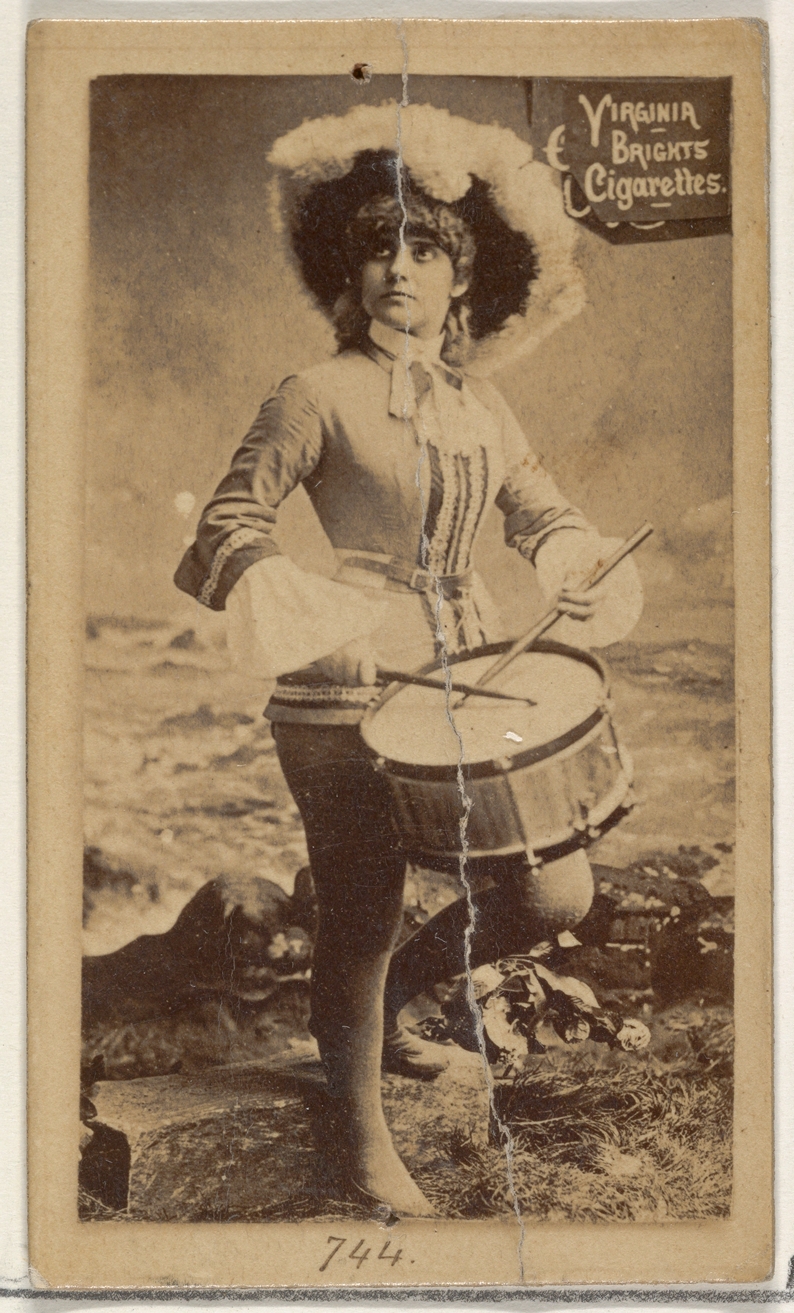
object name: photograph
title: Card 744, from the Actors and Actresses series (N45, Type 2) for Virginia Brights Cigarettes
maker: allen & ginter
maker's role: publisher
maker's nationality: american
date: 1888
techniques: albumen silver print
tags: portraits,women,drums,actresses